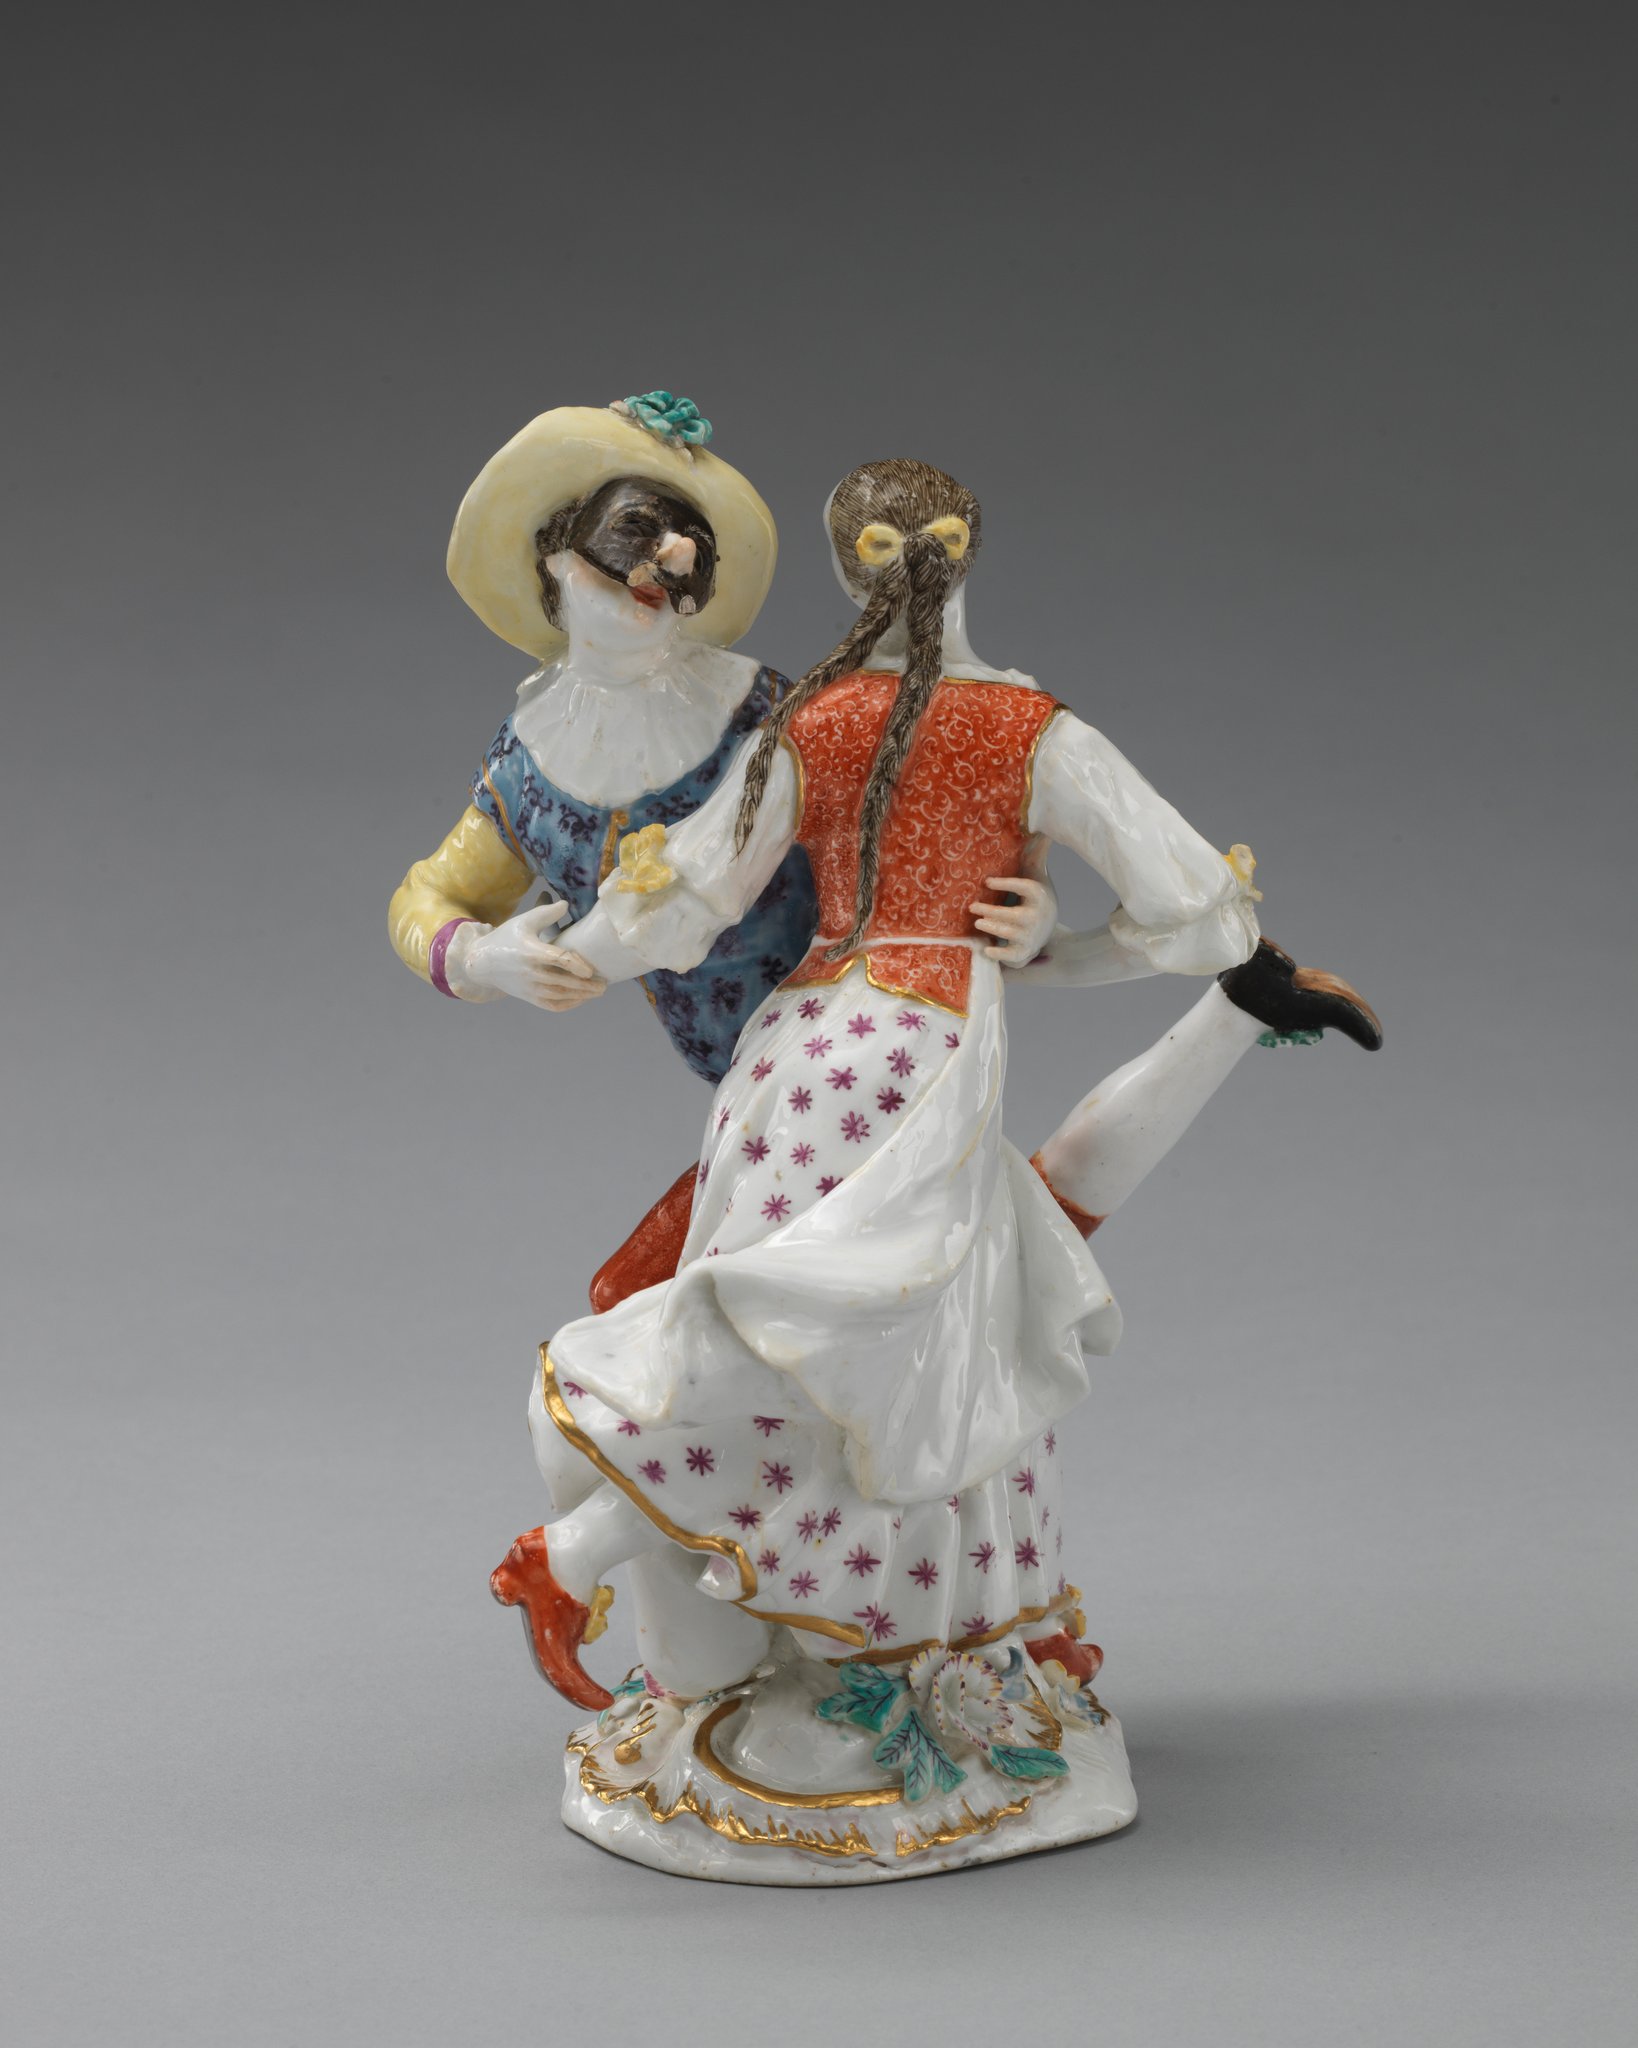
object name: group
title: Dutch dancers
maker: chelsea porcelain manufactory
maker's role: factory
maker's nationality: british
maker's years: 1744-1784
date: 1755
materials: soft paste porcelain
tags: men,women,dancing,dancers